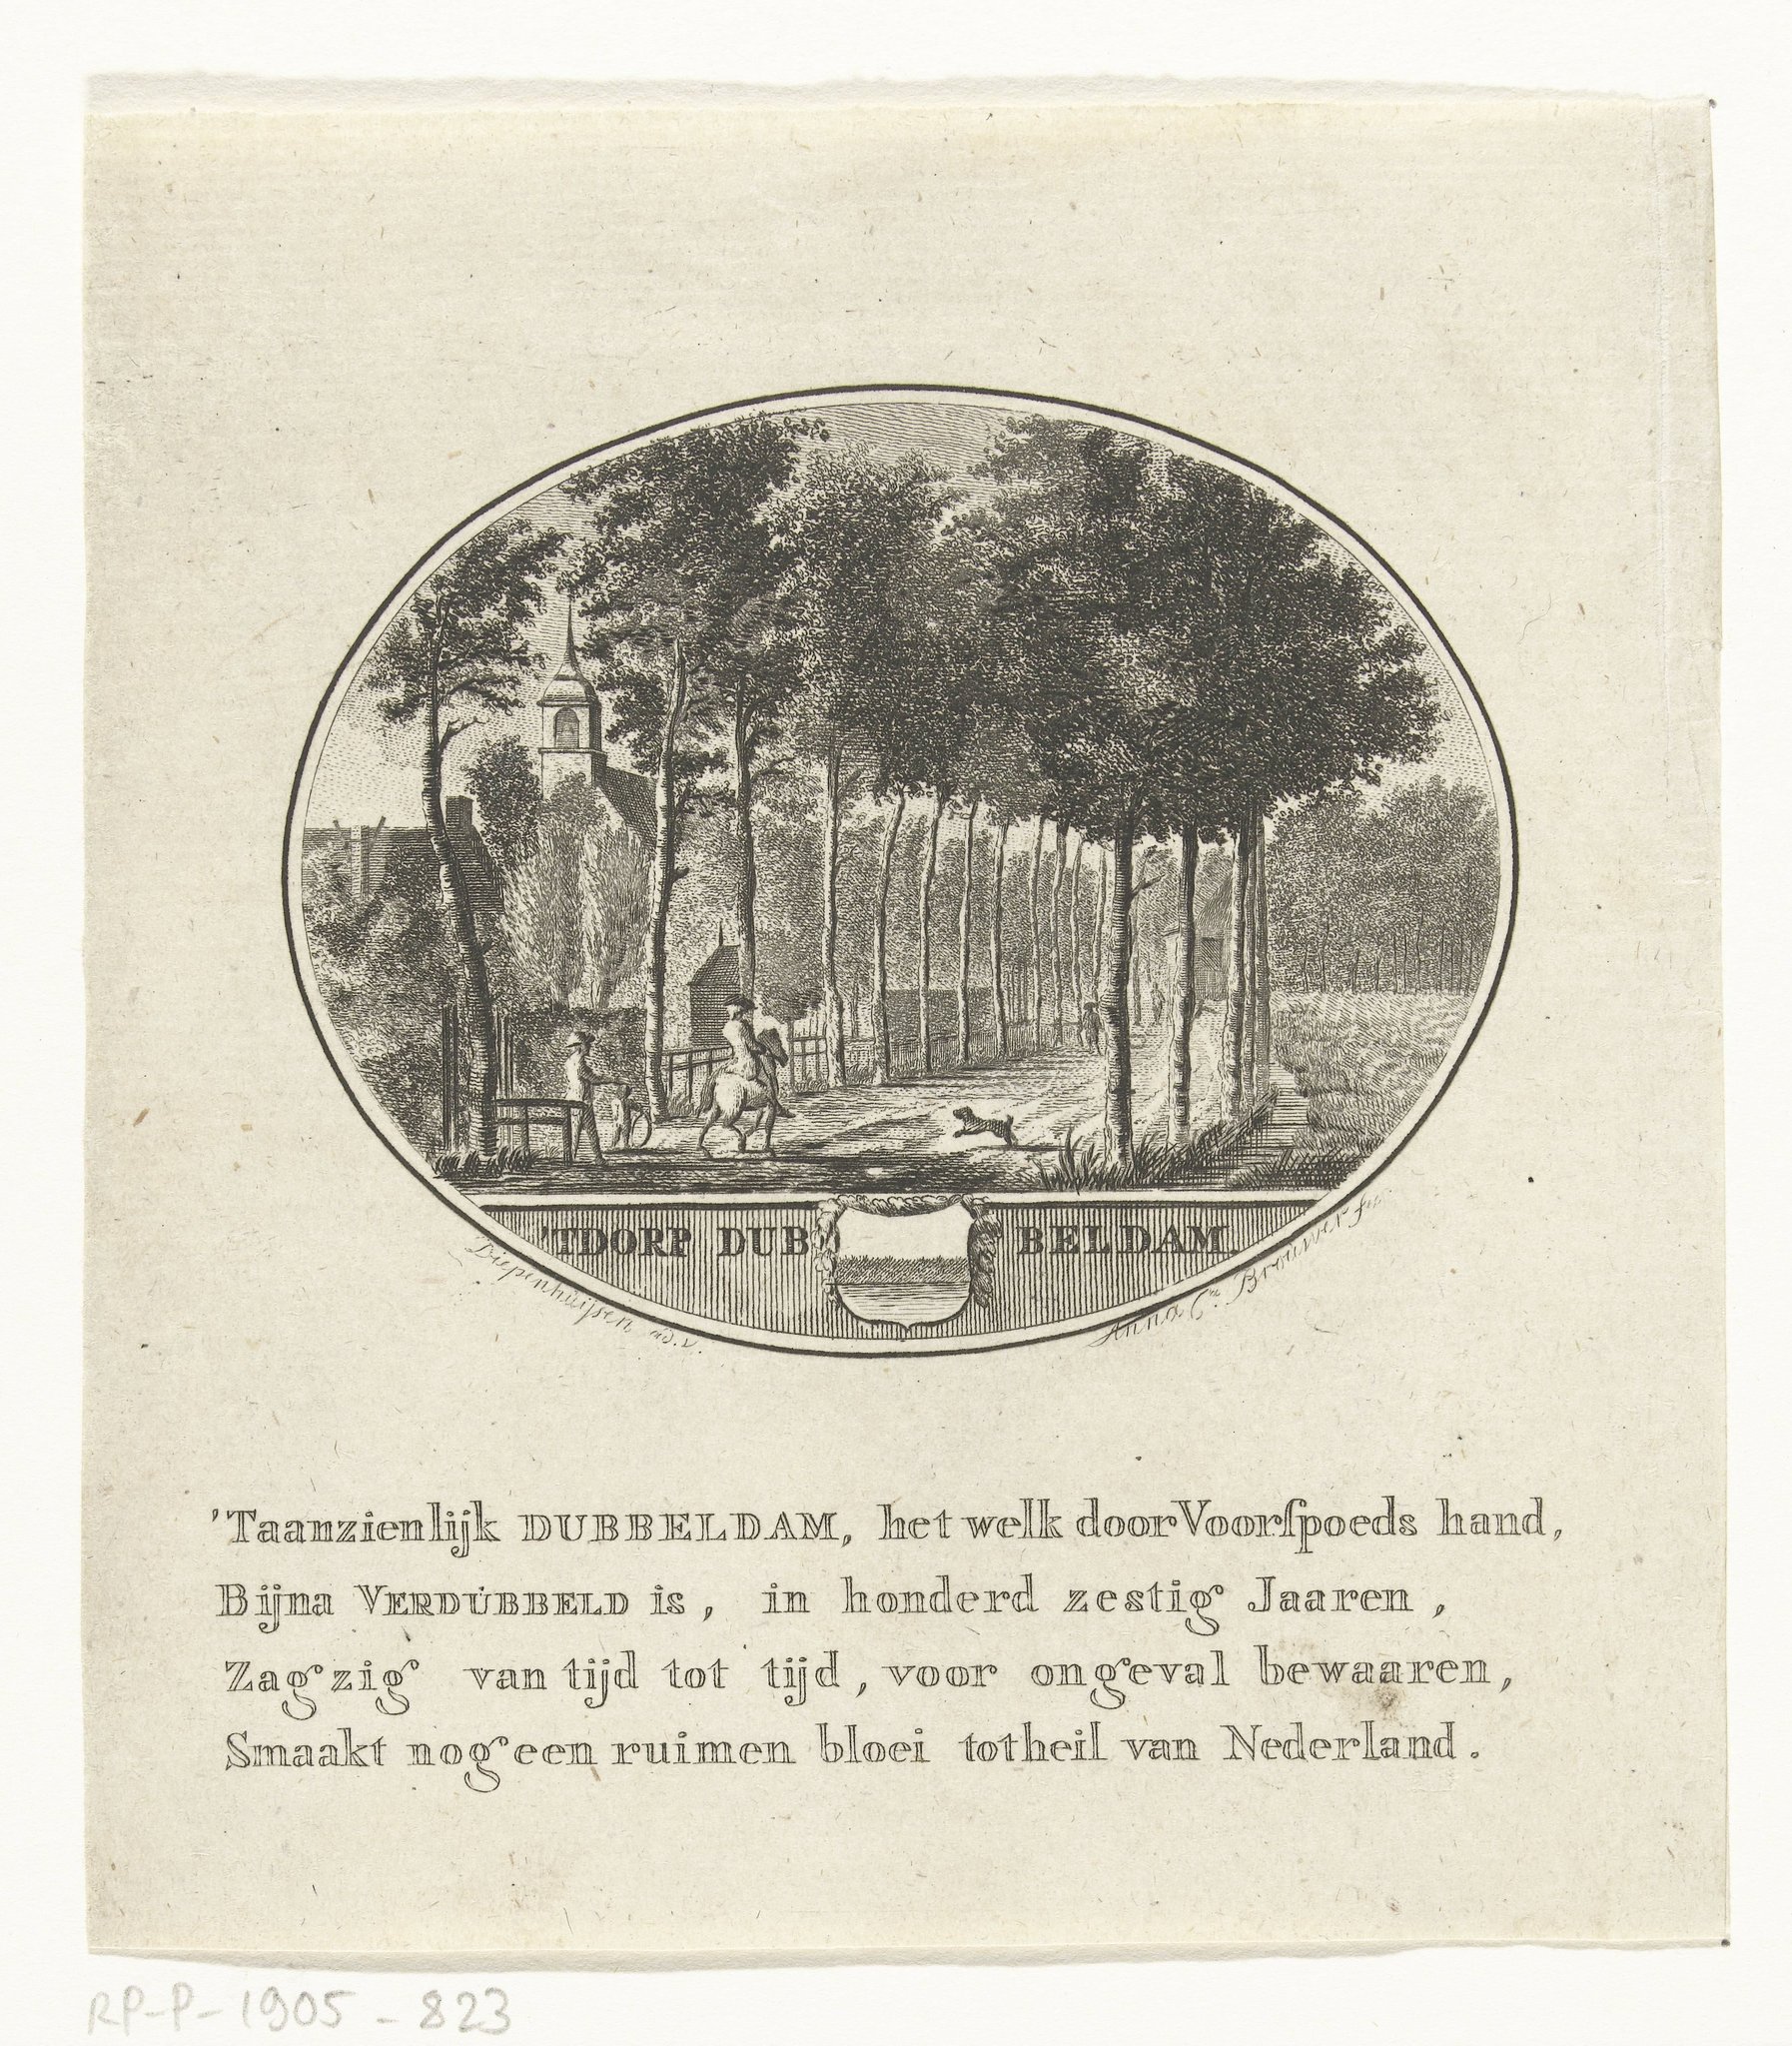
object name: print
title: Gezicht op een laan naar het dorp Dubbeldam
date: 1791-1793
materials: paper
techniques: etching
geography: amsterdam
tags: city-view in general; 'veduta', lane, alley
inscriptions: collector's mark: Lugt 2228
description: afkomstig uit: L. van Ollefen, De Nederlandsche stad- en dorp-beschrijver. Deel 1, Amsterdam: Hendrik Arend Banse, 1793.